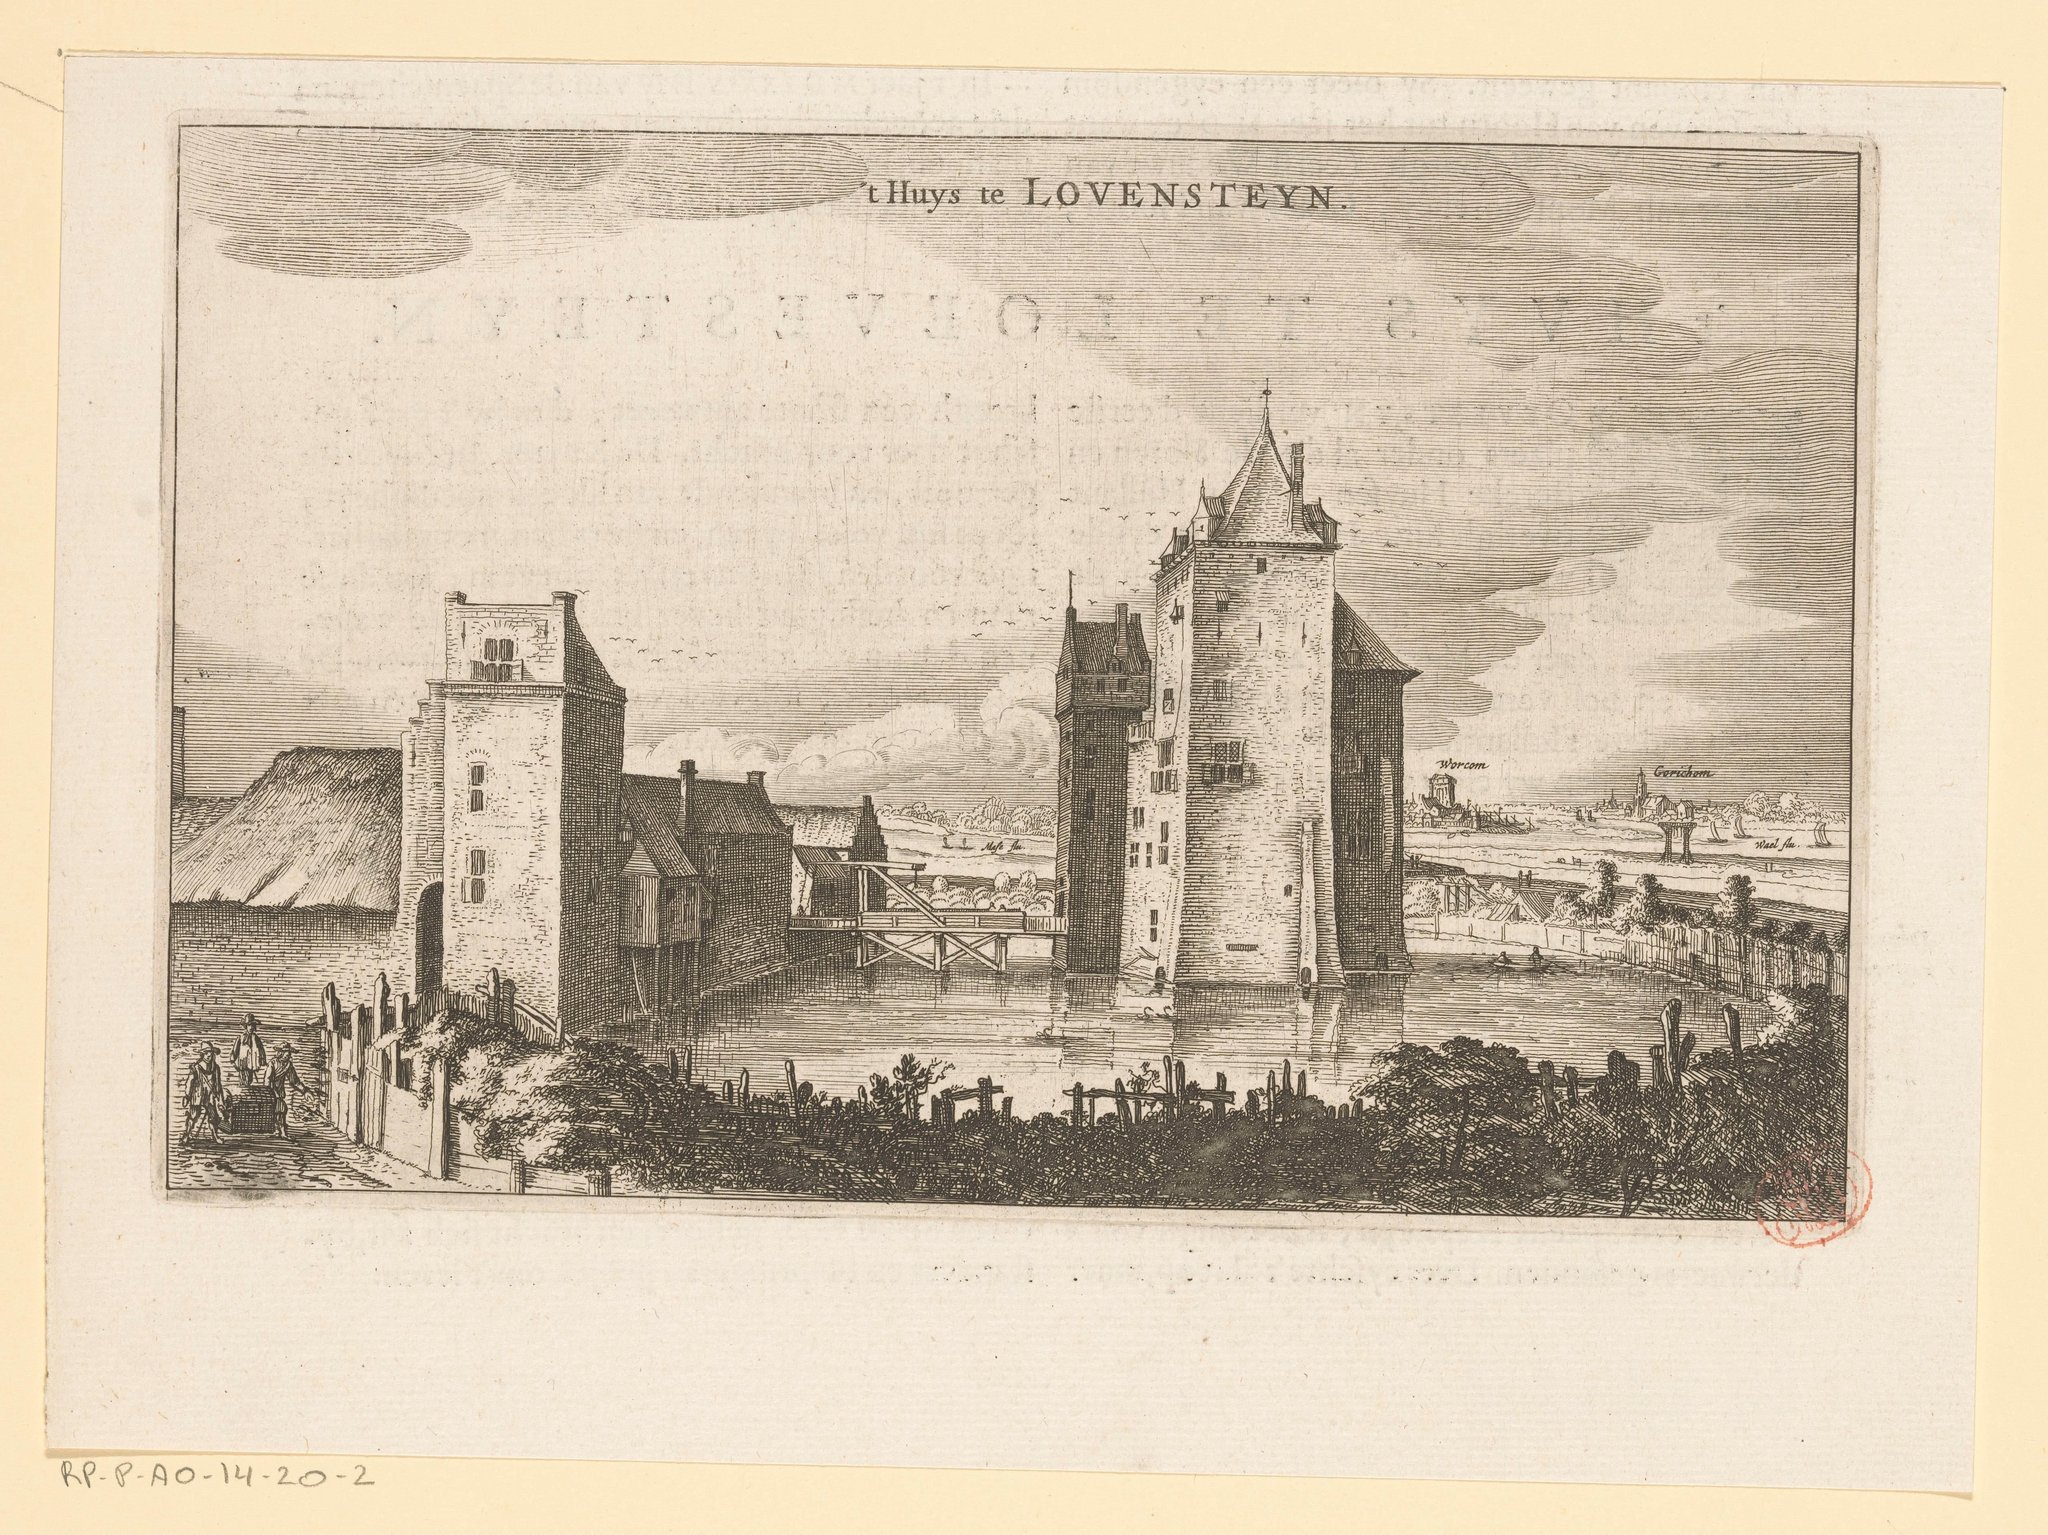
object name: print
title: 't Huys te Lovensteyn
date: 1652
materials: paper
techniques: engraving, etching, letterpress printing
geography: amsterdam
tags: delft, hugo de groot, castle, law and jurisprudence (+ escape from prison), loevestein castle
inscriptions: collector's mark: Lugt 195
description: Prent gebruikt in: Blaeu, Johannes Willemszoon. Toonneel der steden van de Vereenighde Nederlanden. 2 delen. Amsterdam: Johannes Willemszoon Blaeu, 1652, dl. 1. Gelijkzijdige kopie naar de oorspronkelijke ets door Claes Jansz. Visscher (II), FMH 1405.